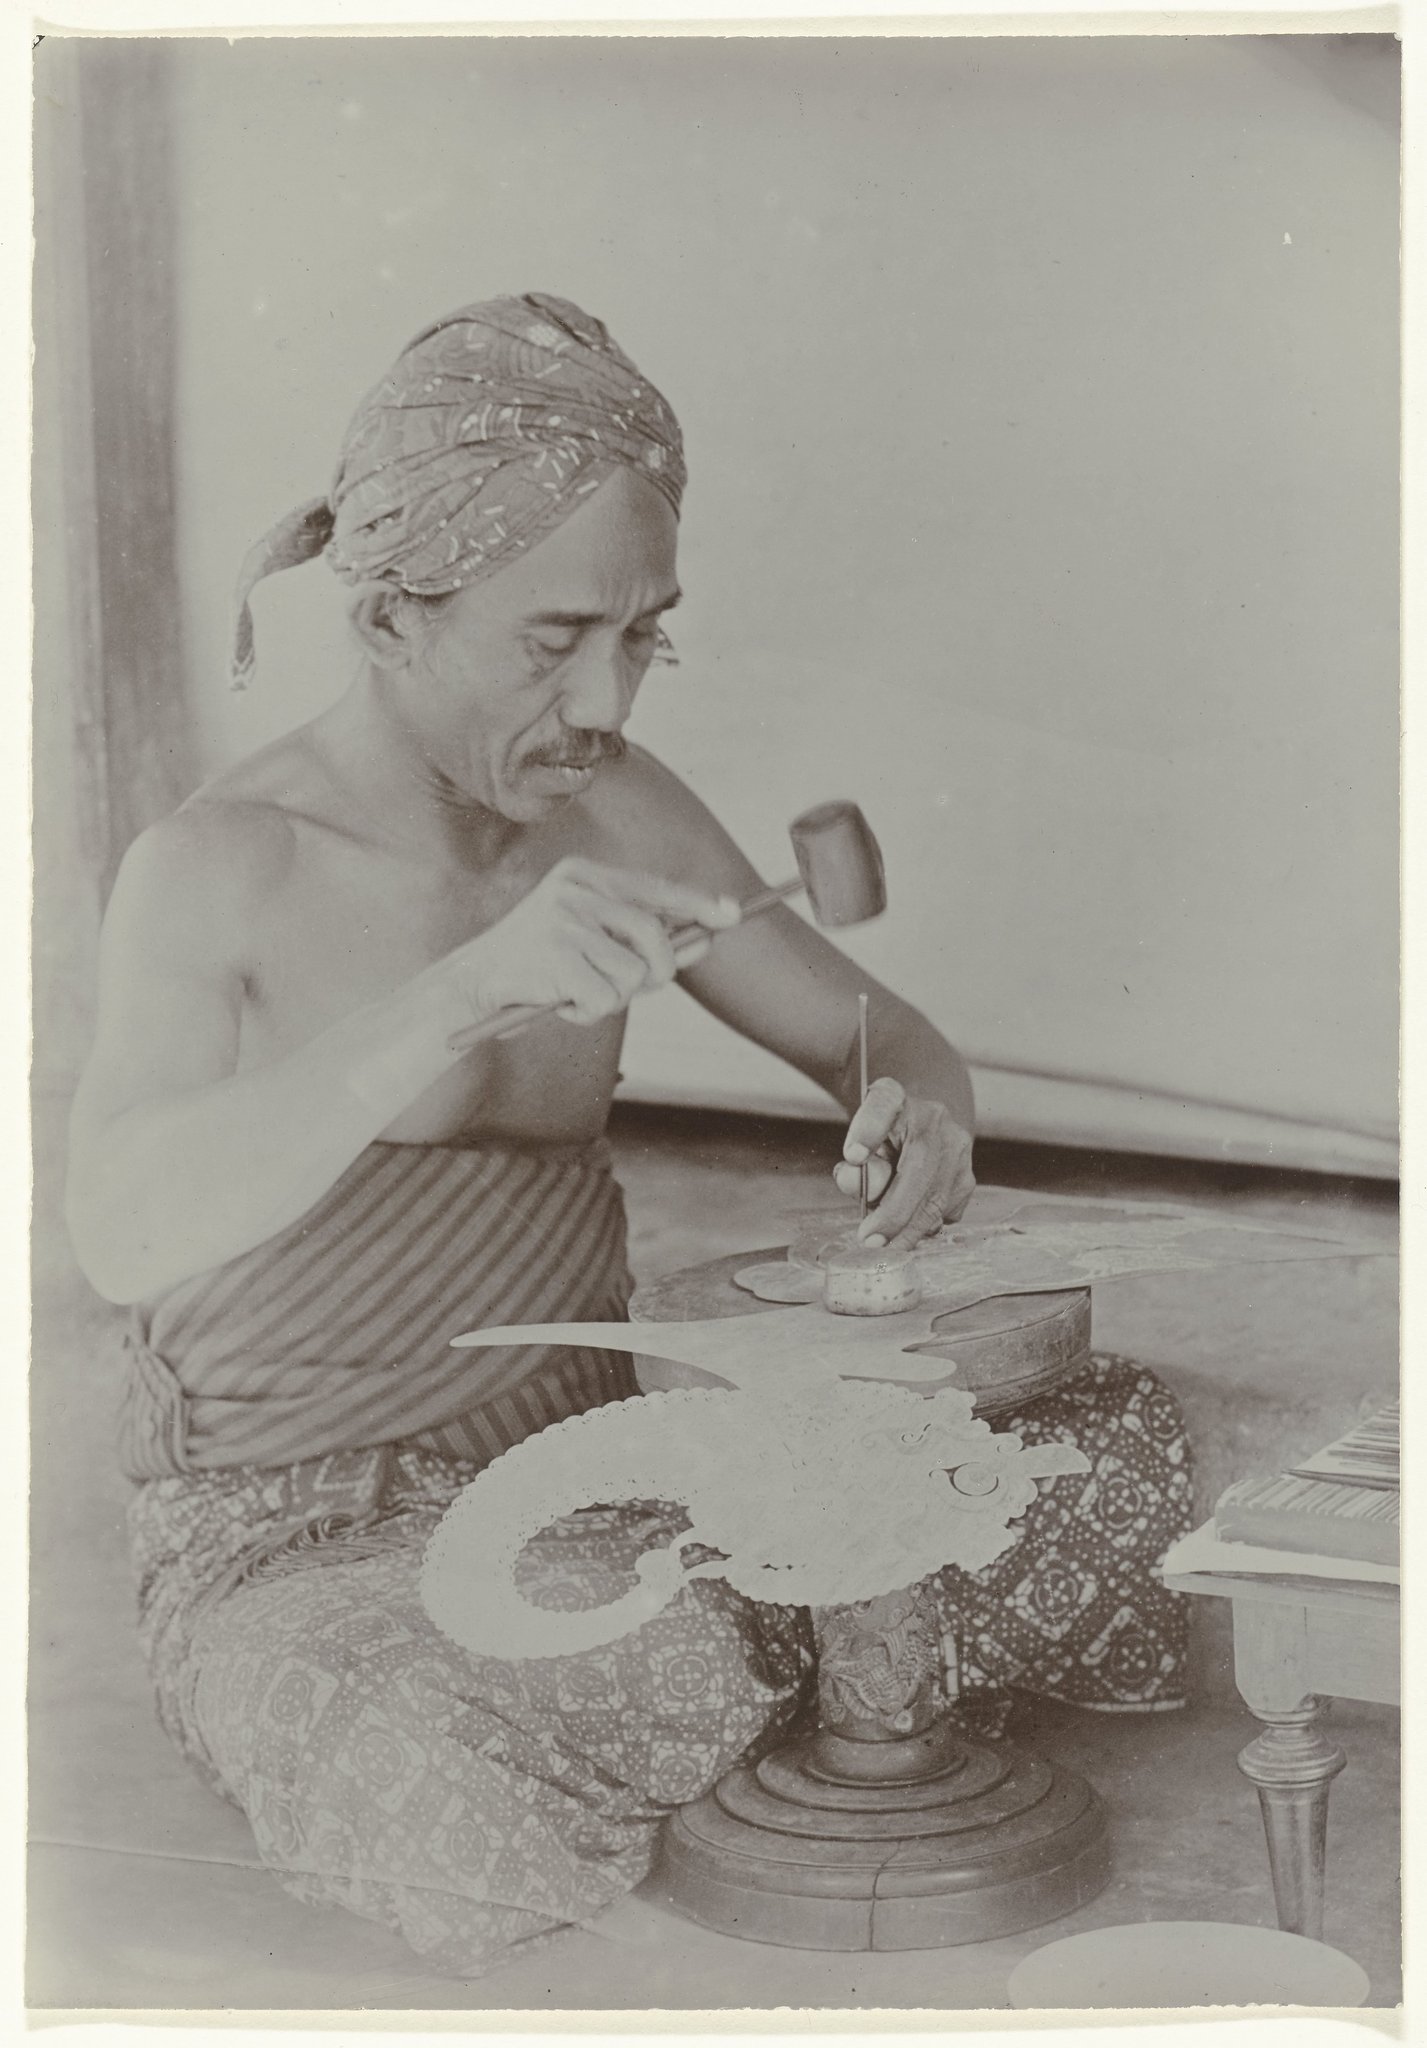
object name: photograph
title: Javaanse man maakt met hamer en instrumenten een afbeelding gelijkend een menselijk gestalte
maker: kassian céphas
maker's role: fotograaf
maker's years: 1845-1912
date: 1867-1910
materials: cardboard, paper, photographic support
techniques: albumen print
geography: java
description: De man draagt een sarong met batik motief en een hoofddoek.